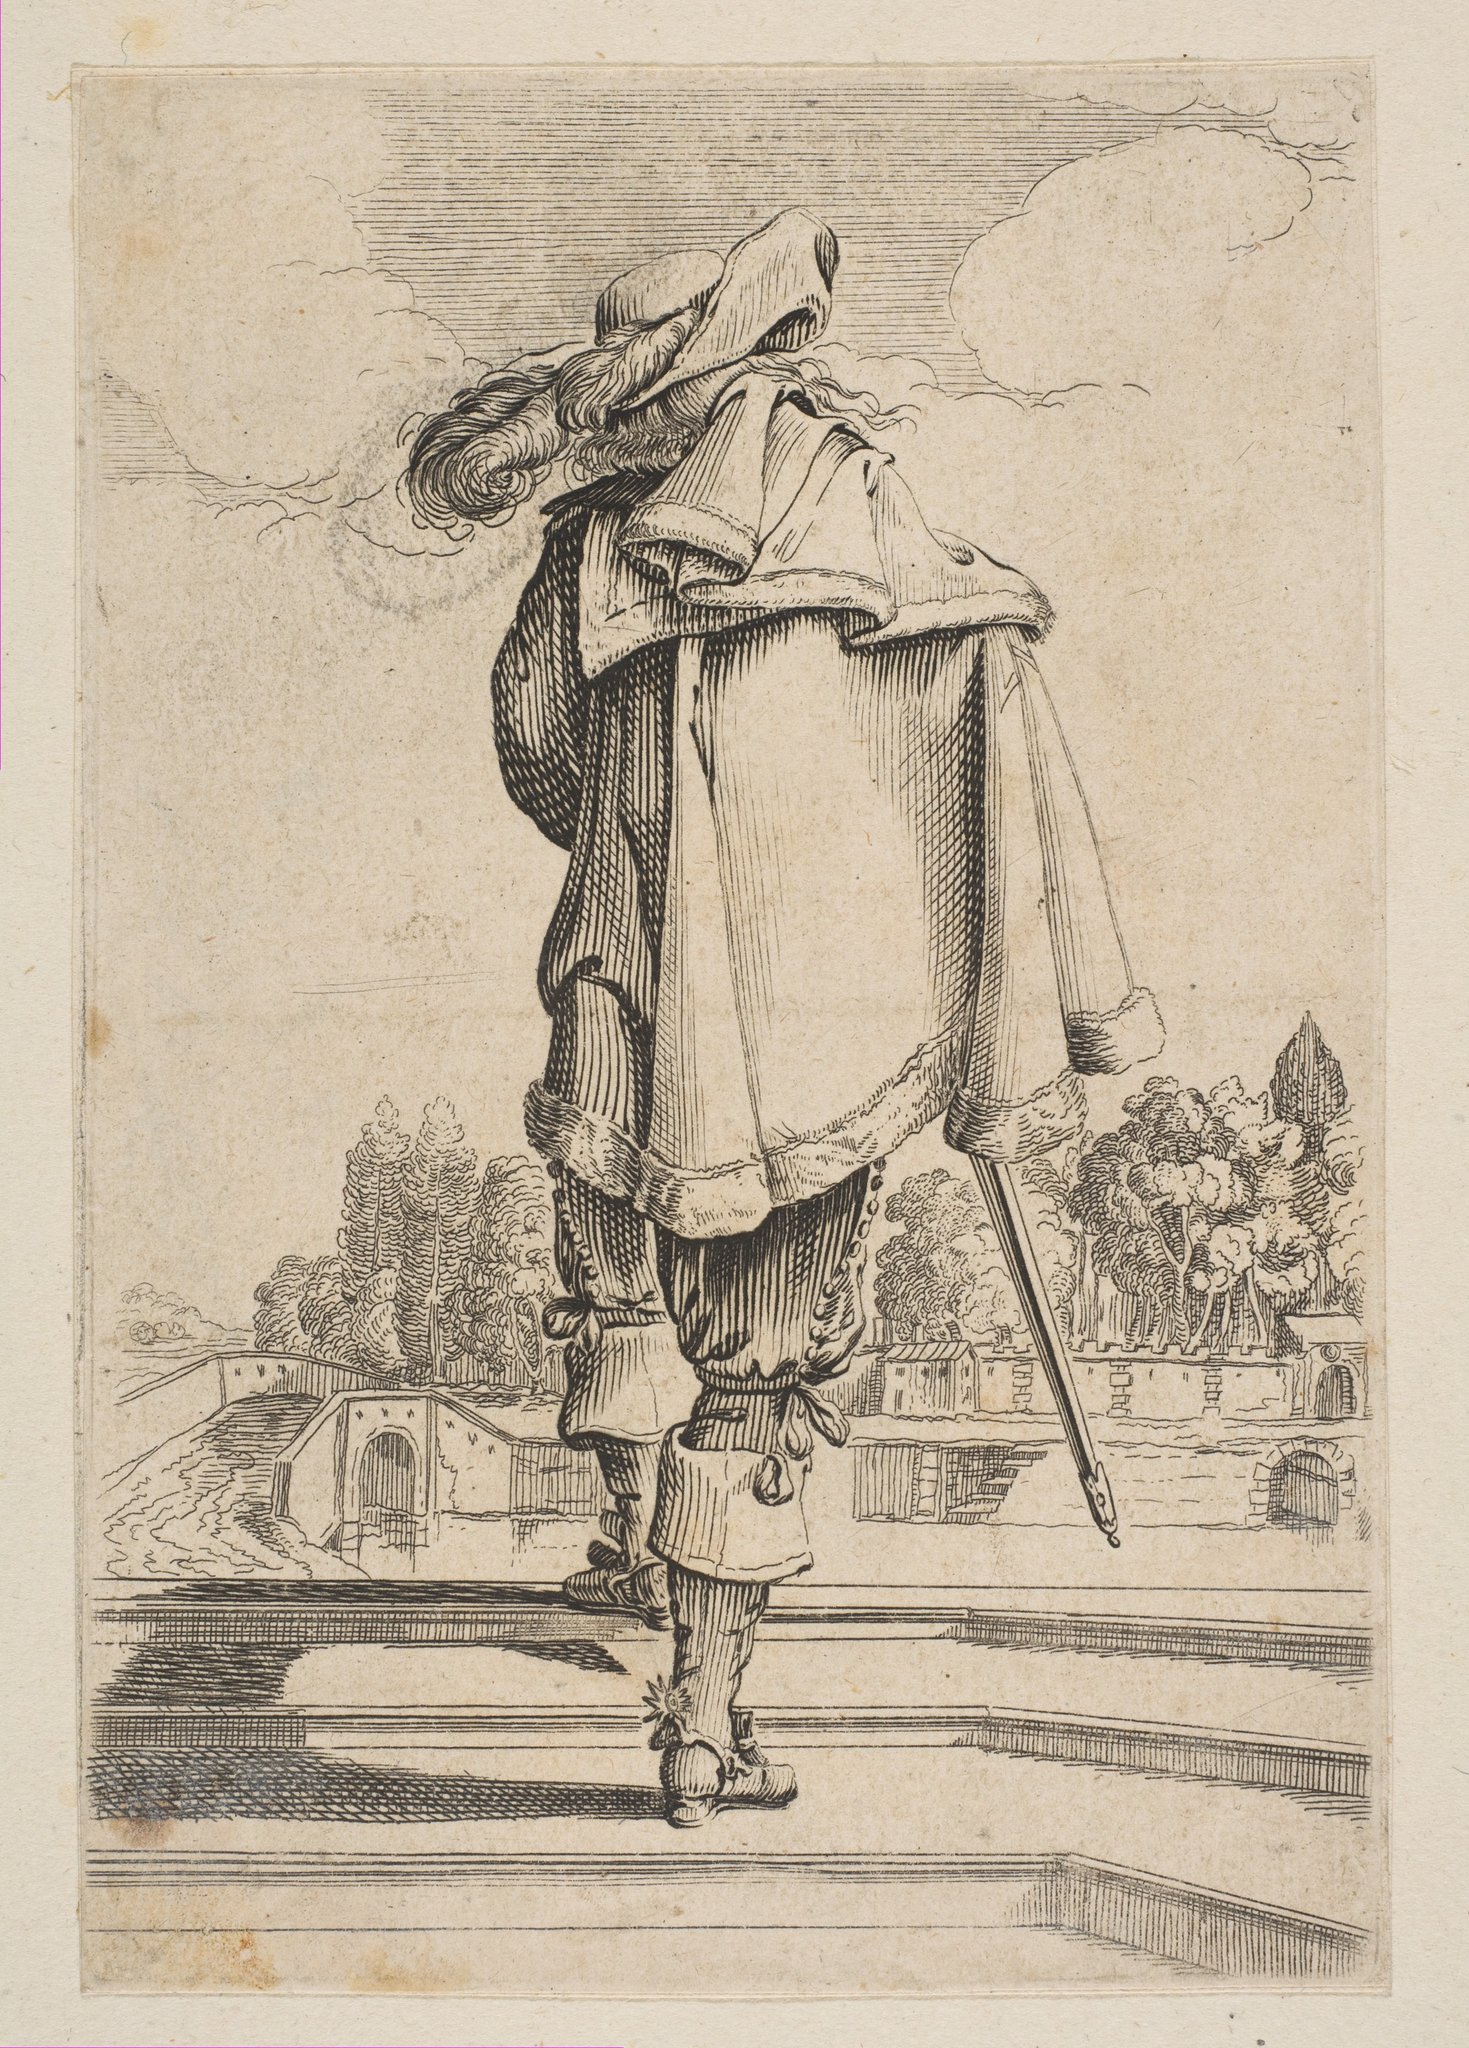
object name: print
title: Gentleman in a Cape and Plumed Hat Seen from the Back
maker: anonymous, french, 17th century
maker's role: artist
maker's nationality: french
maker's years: 1600-1700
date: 1629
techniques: etching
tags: hats,men